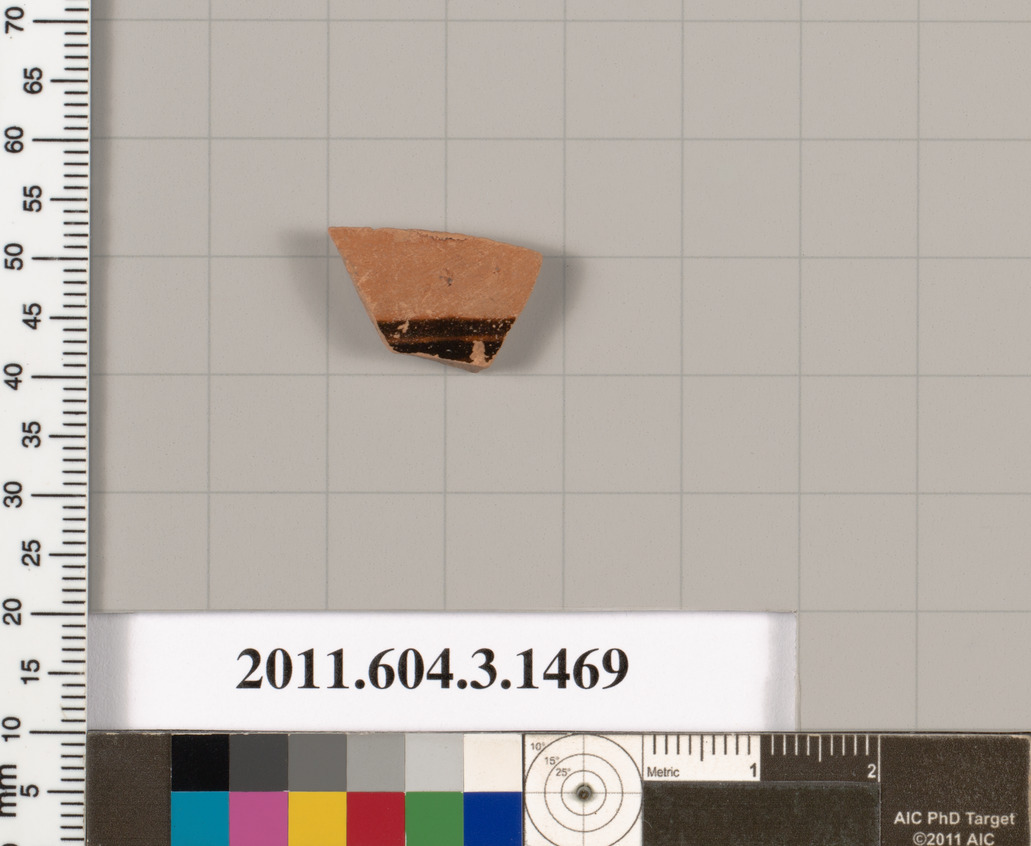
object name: skyphos fragment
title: Terracotta fragment of a skyphos (deep drinking cup)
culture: greek, attic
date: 600-401 BCE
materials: terracotta